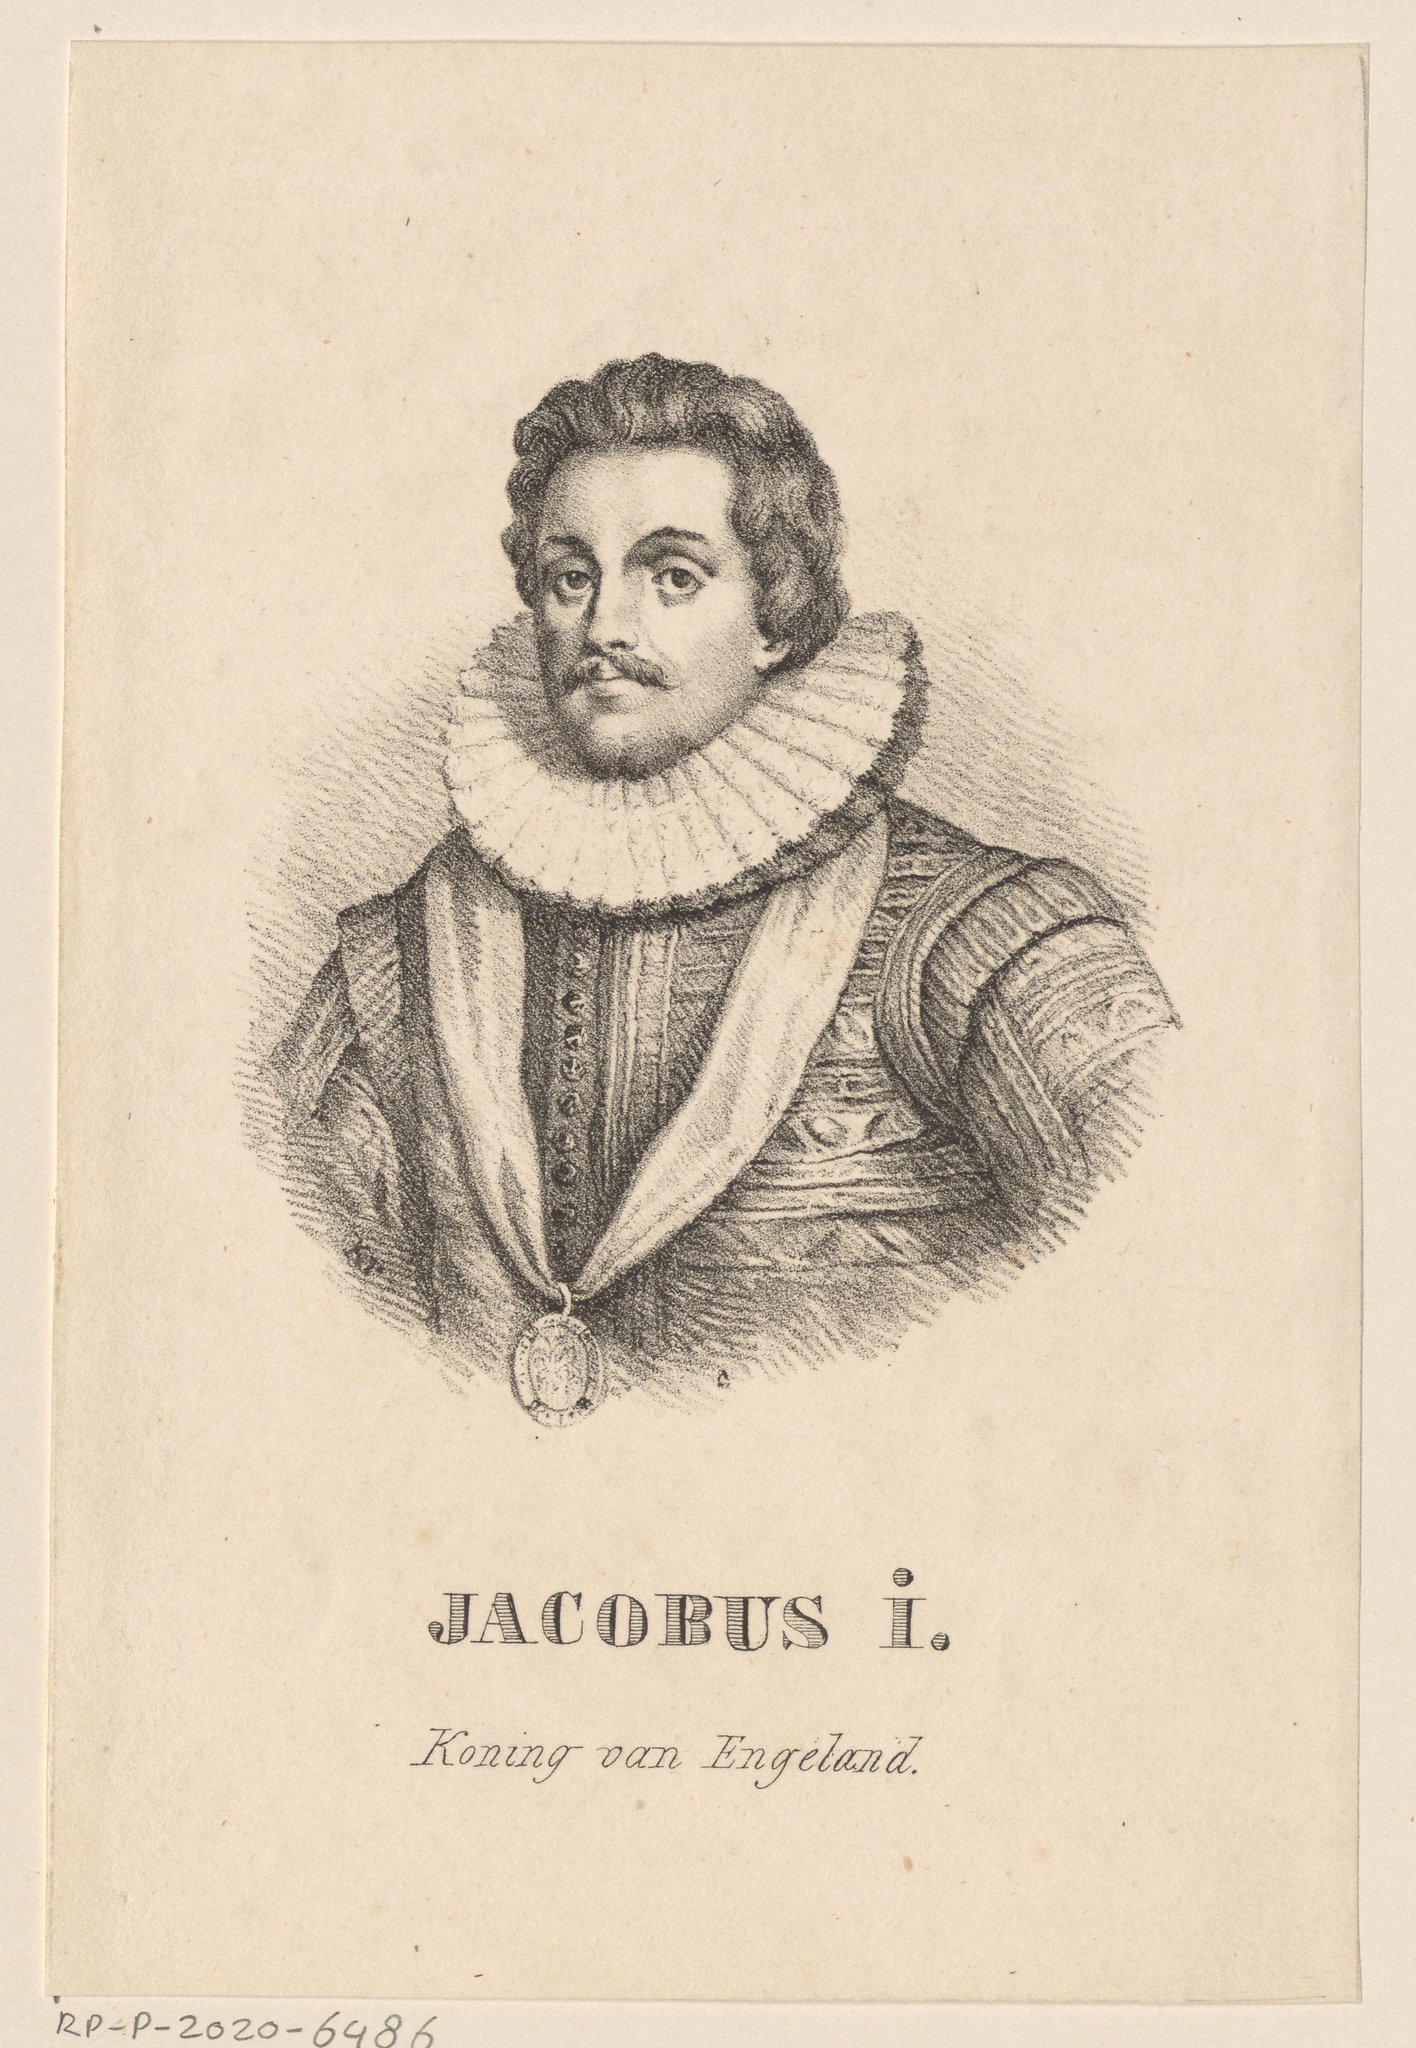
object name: print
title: Portret van Jacobus I, koning van Engeland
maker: Anonymous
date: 1800-1849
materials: paper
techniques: lithograph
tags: jacobus i (koning van engeland), historical persons, king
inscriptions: monogram: ‘Kr’